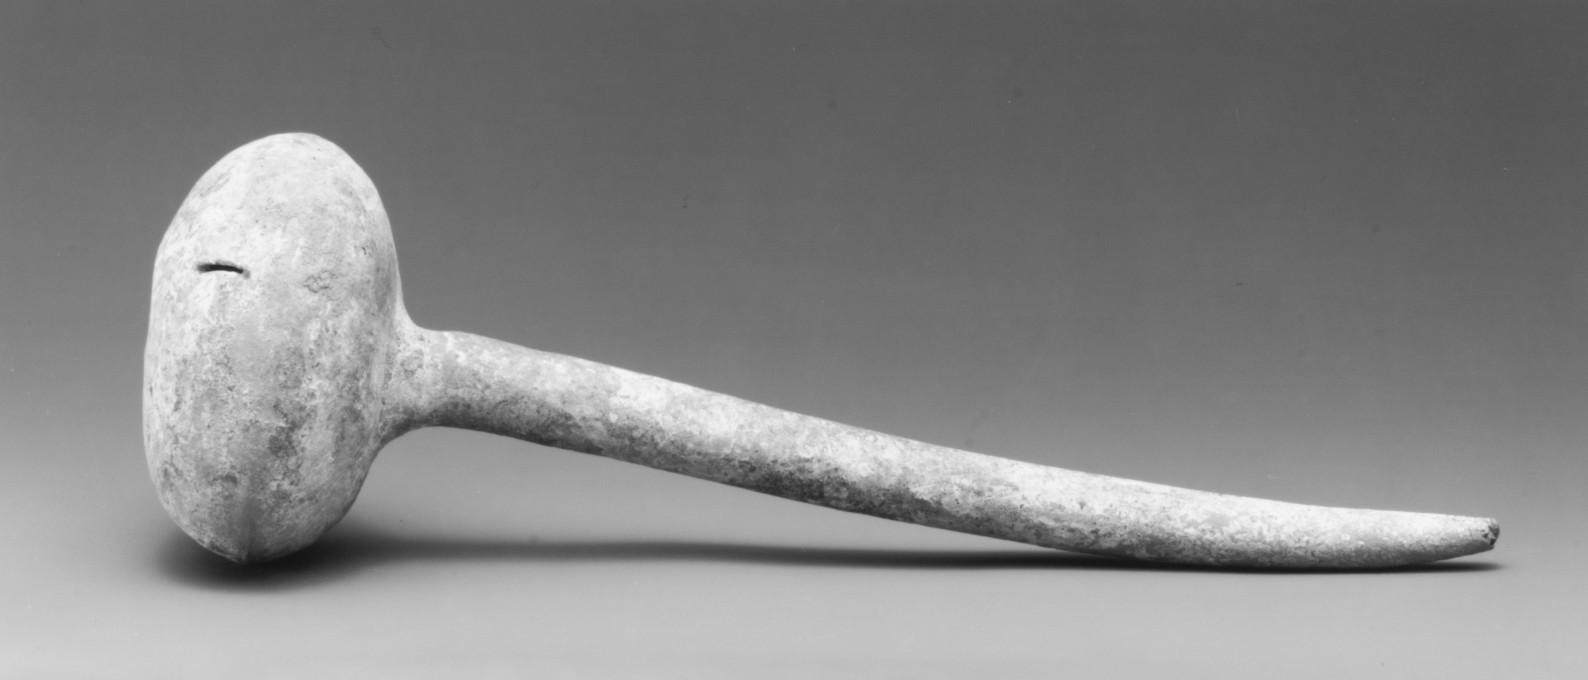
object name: rattle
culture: teotihuacan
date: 400-700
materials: pottery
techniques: polychrome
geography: mexico